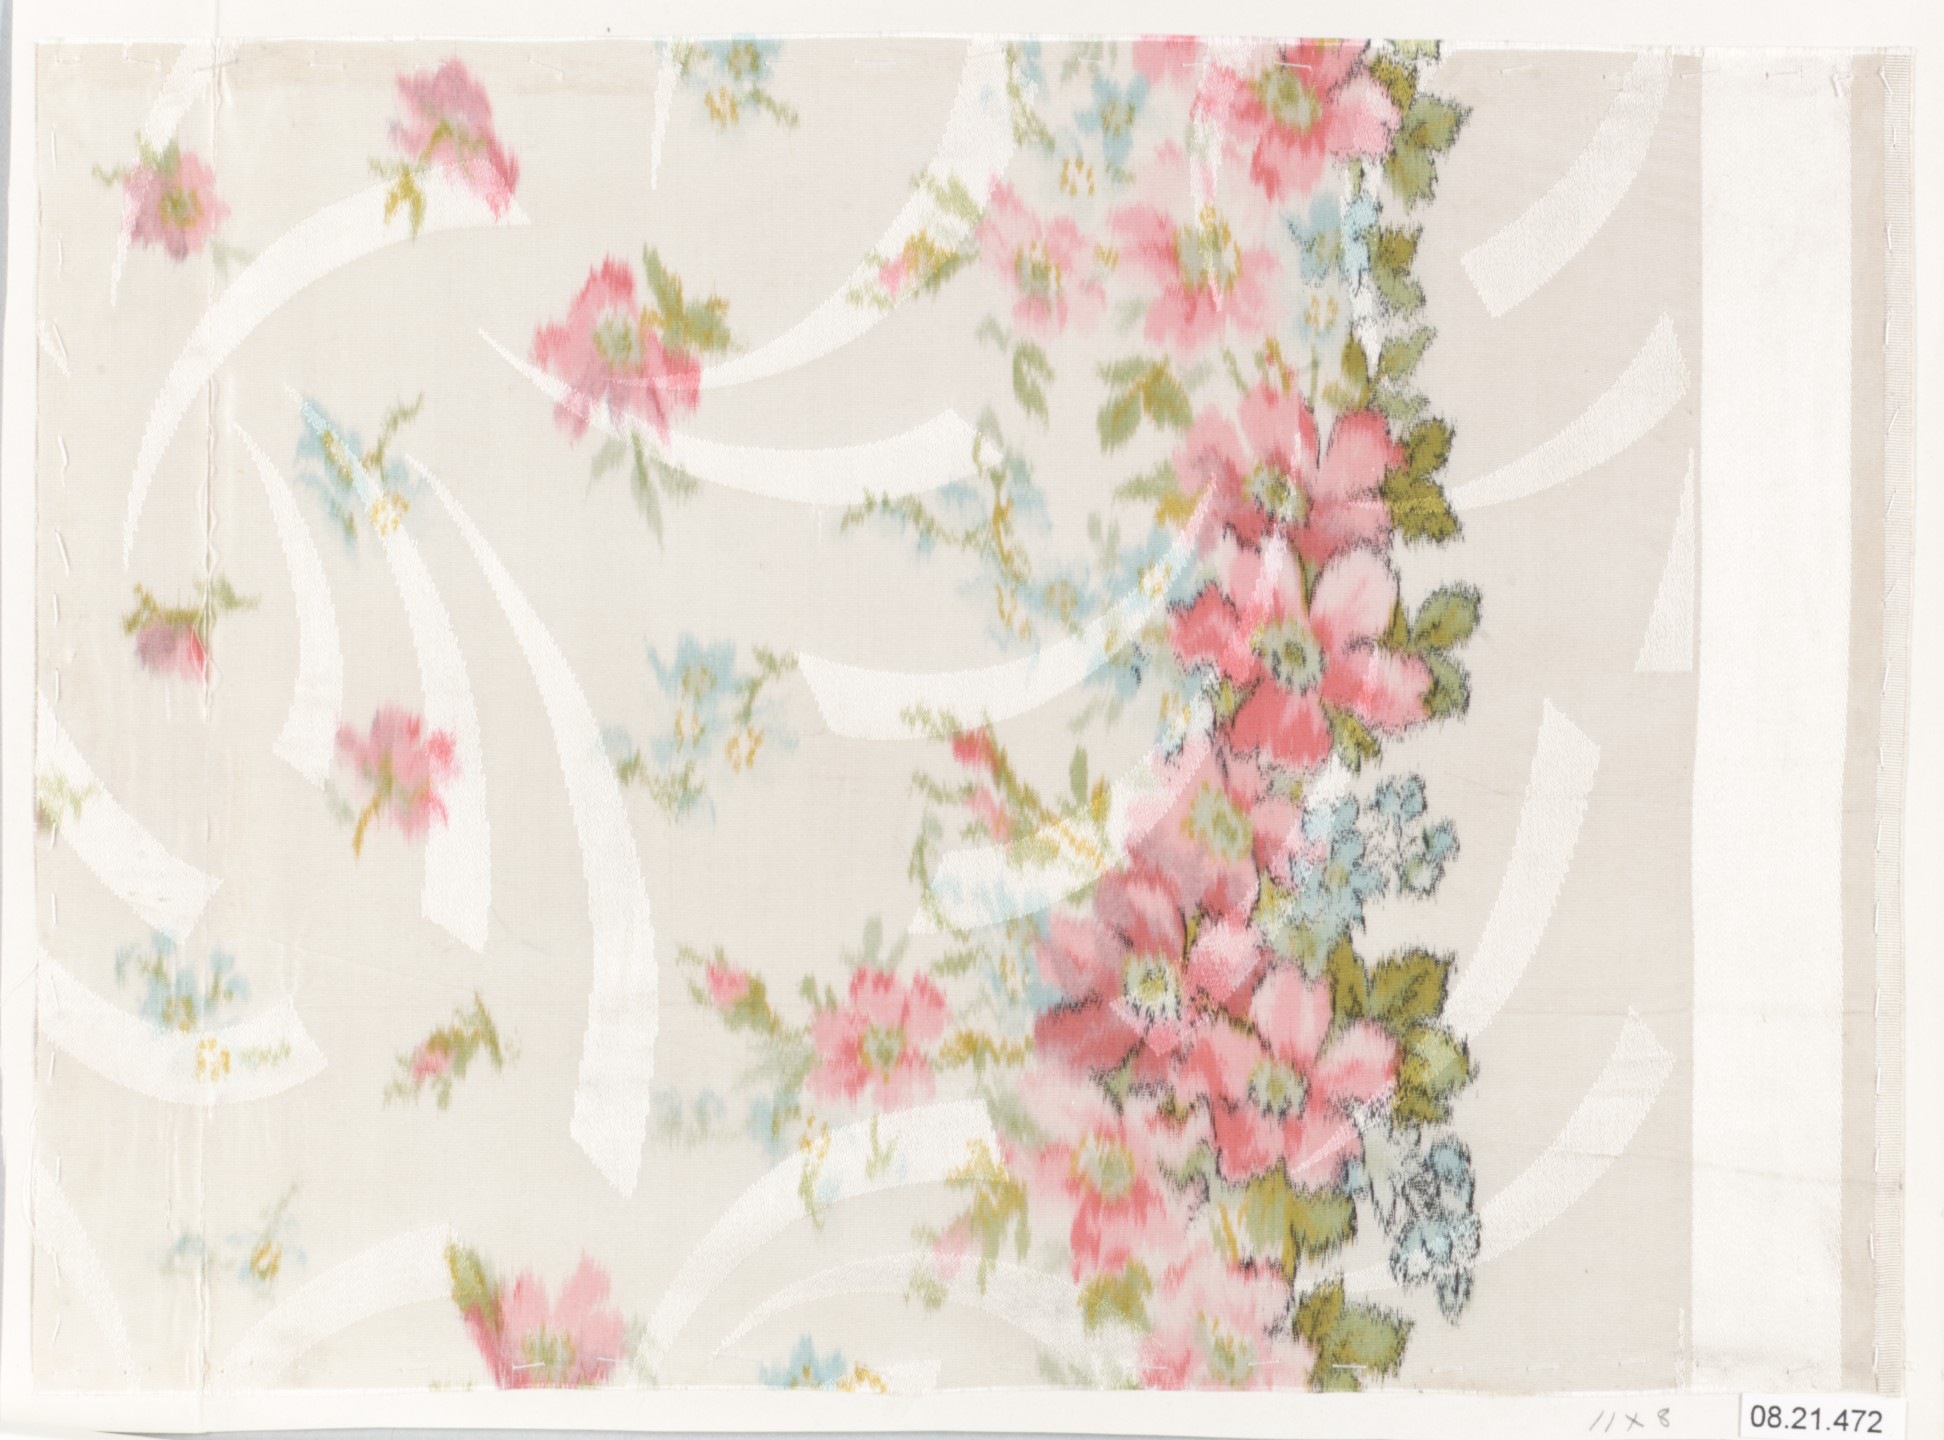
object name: textile sample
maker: Anonymous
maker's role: designer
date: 1900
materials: silk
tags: flowers